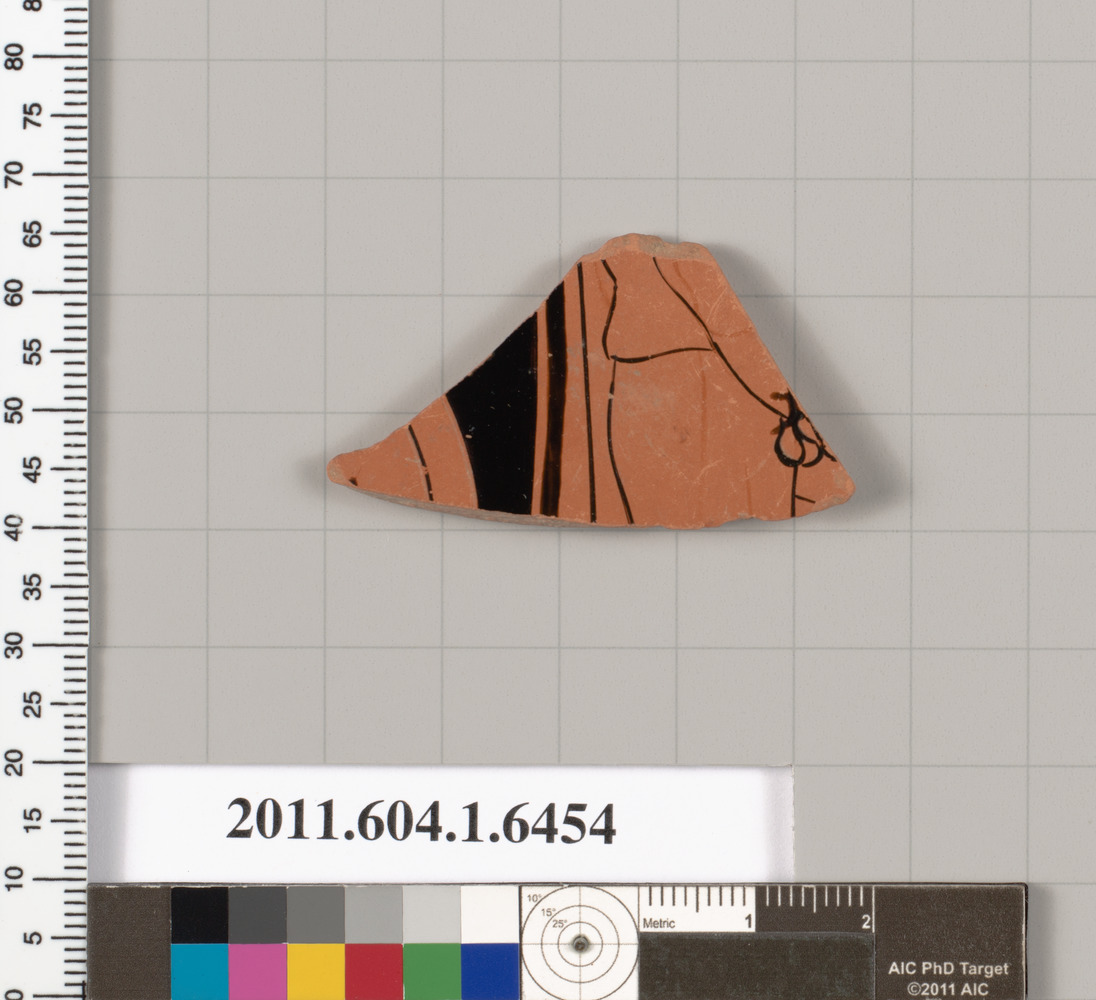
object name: kylix fragment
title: Terracotta fragment of a kylix (drinking cup)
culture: greek, attic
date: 490-480 BCE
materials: terracotta